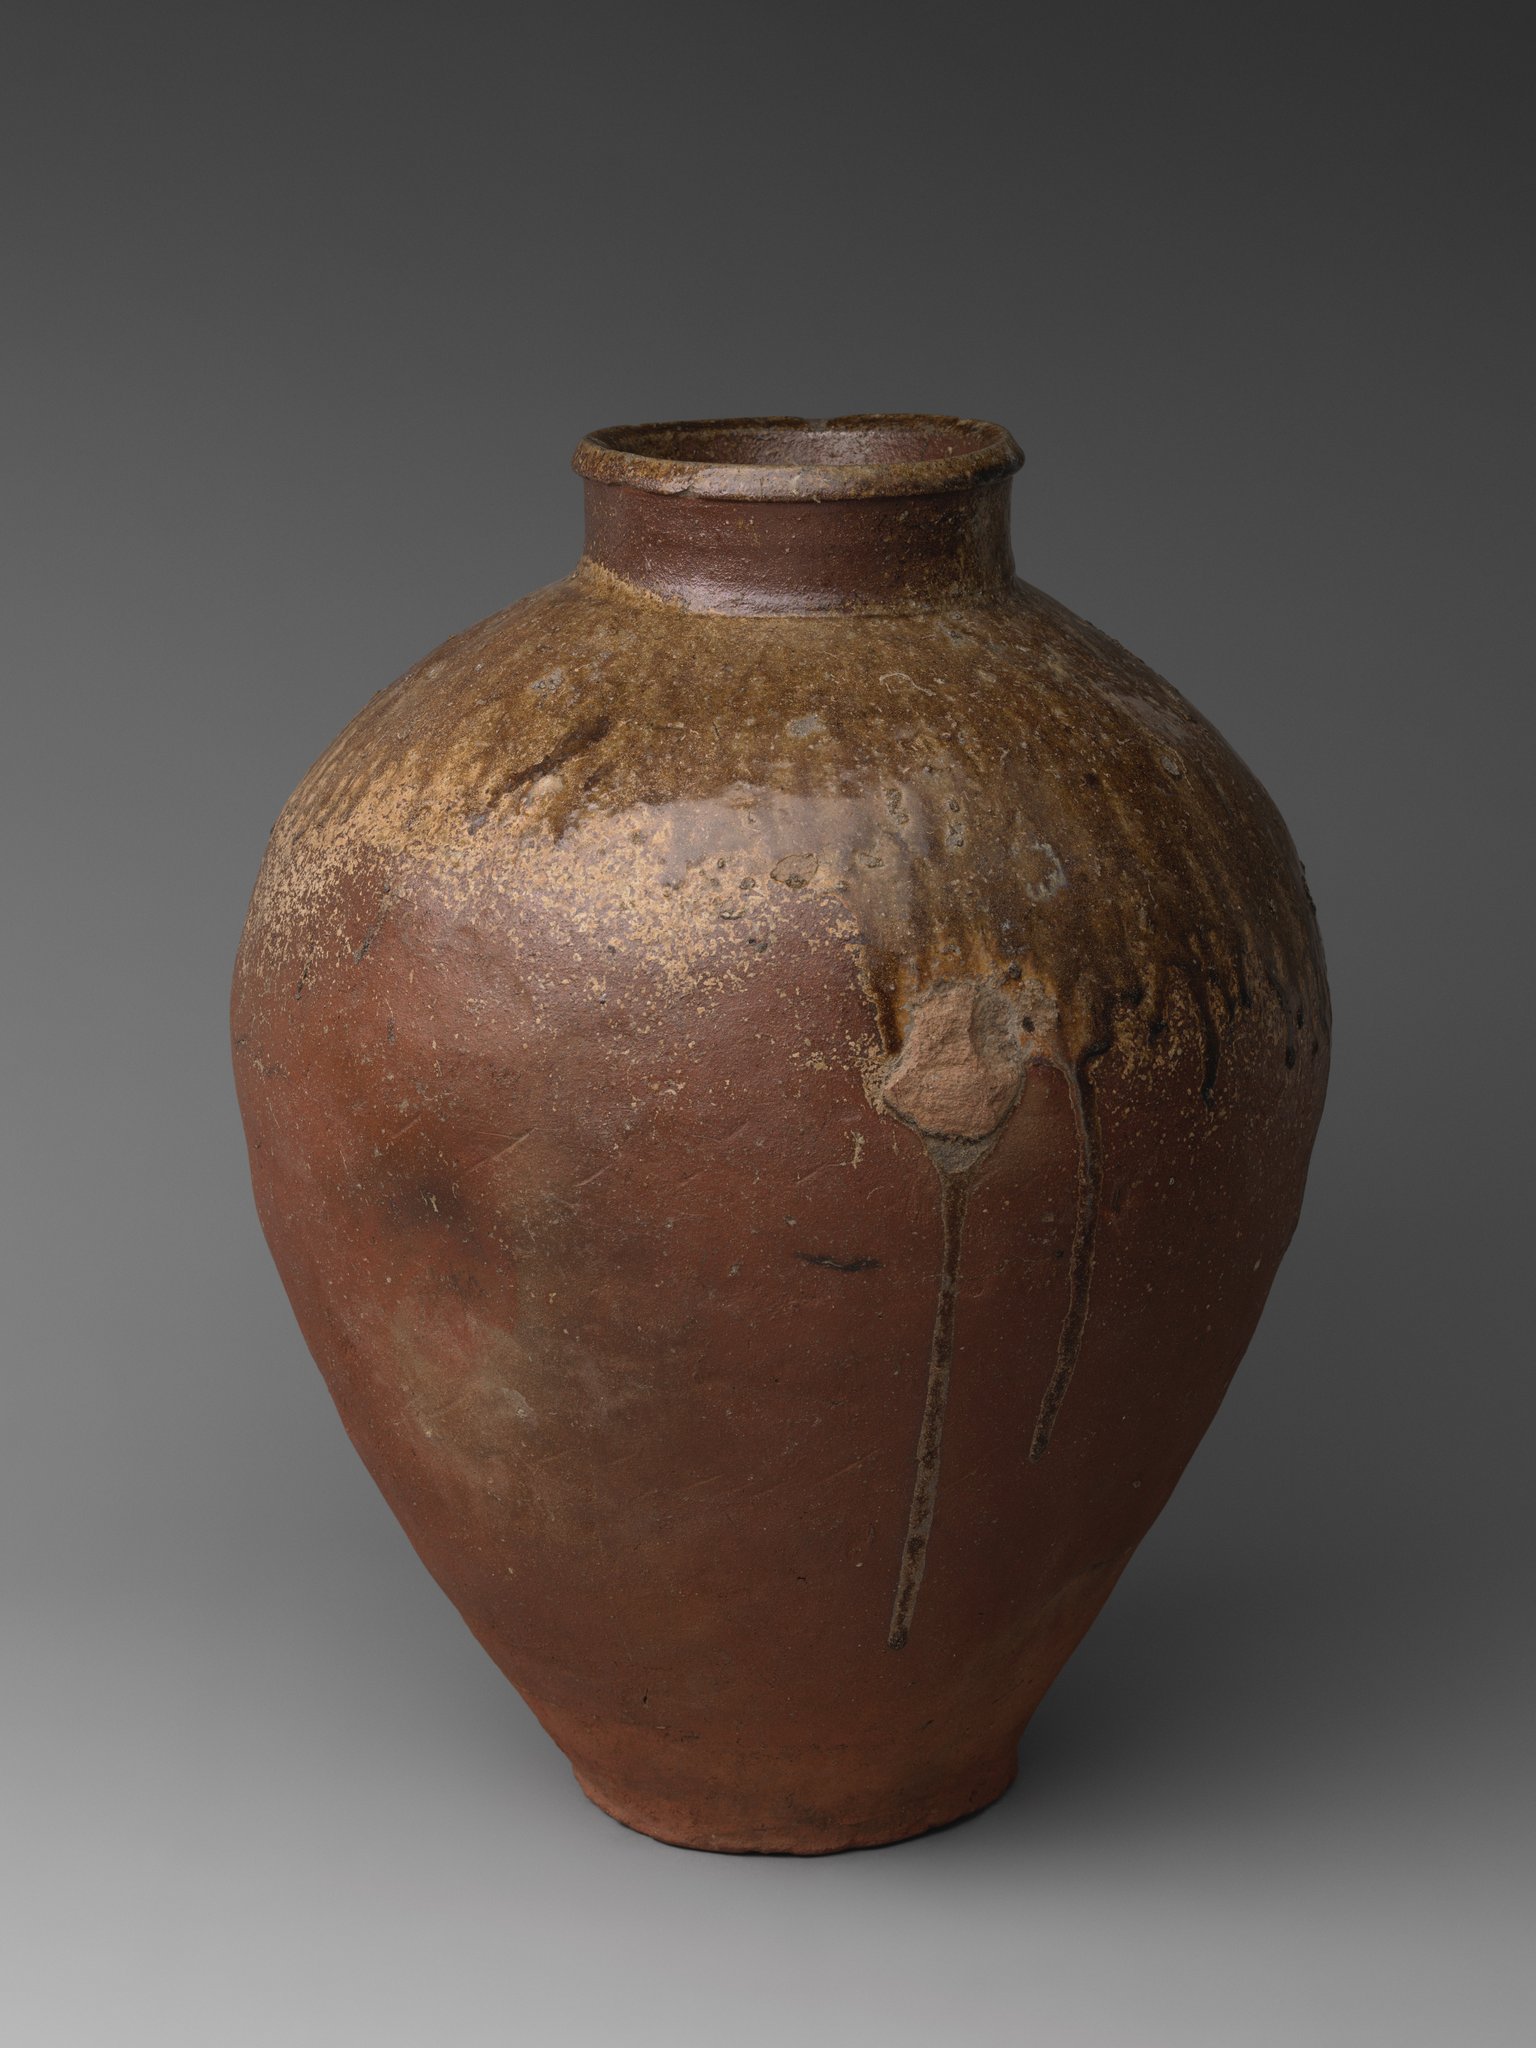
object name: jar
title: Large Storage Jar (Ōtsubo)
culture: japanese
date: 1501-1600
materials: wood, glaze, stoneware